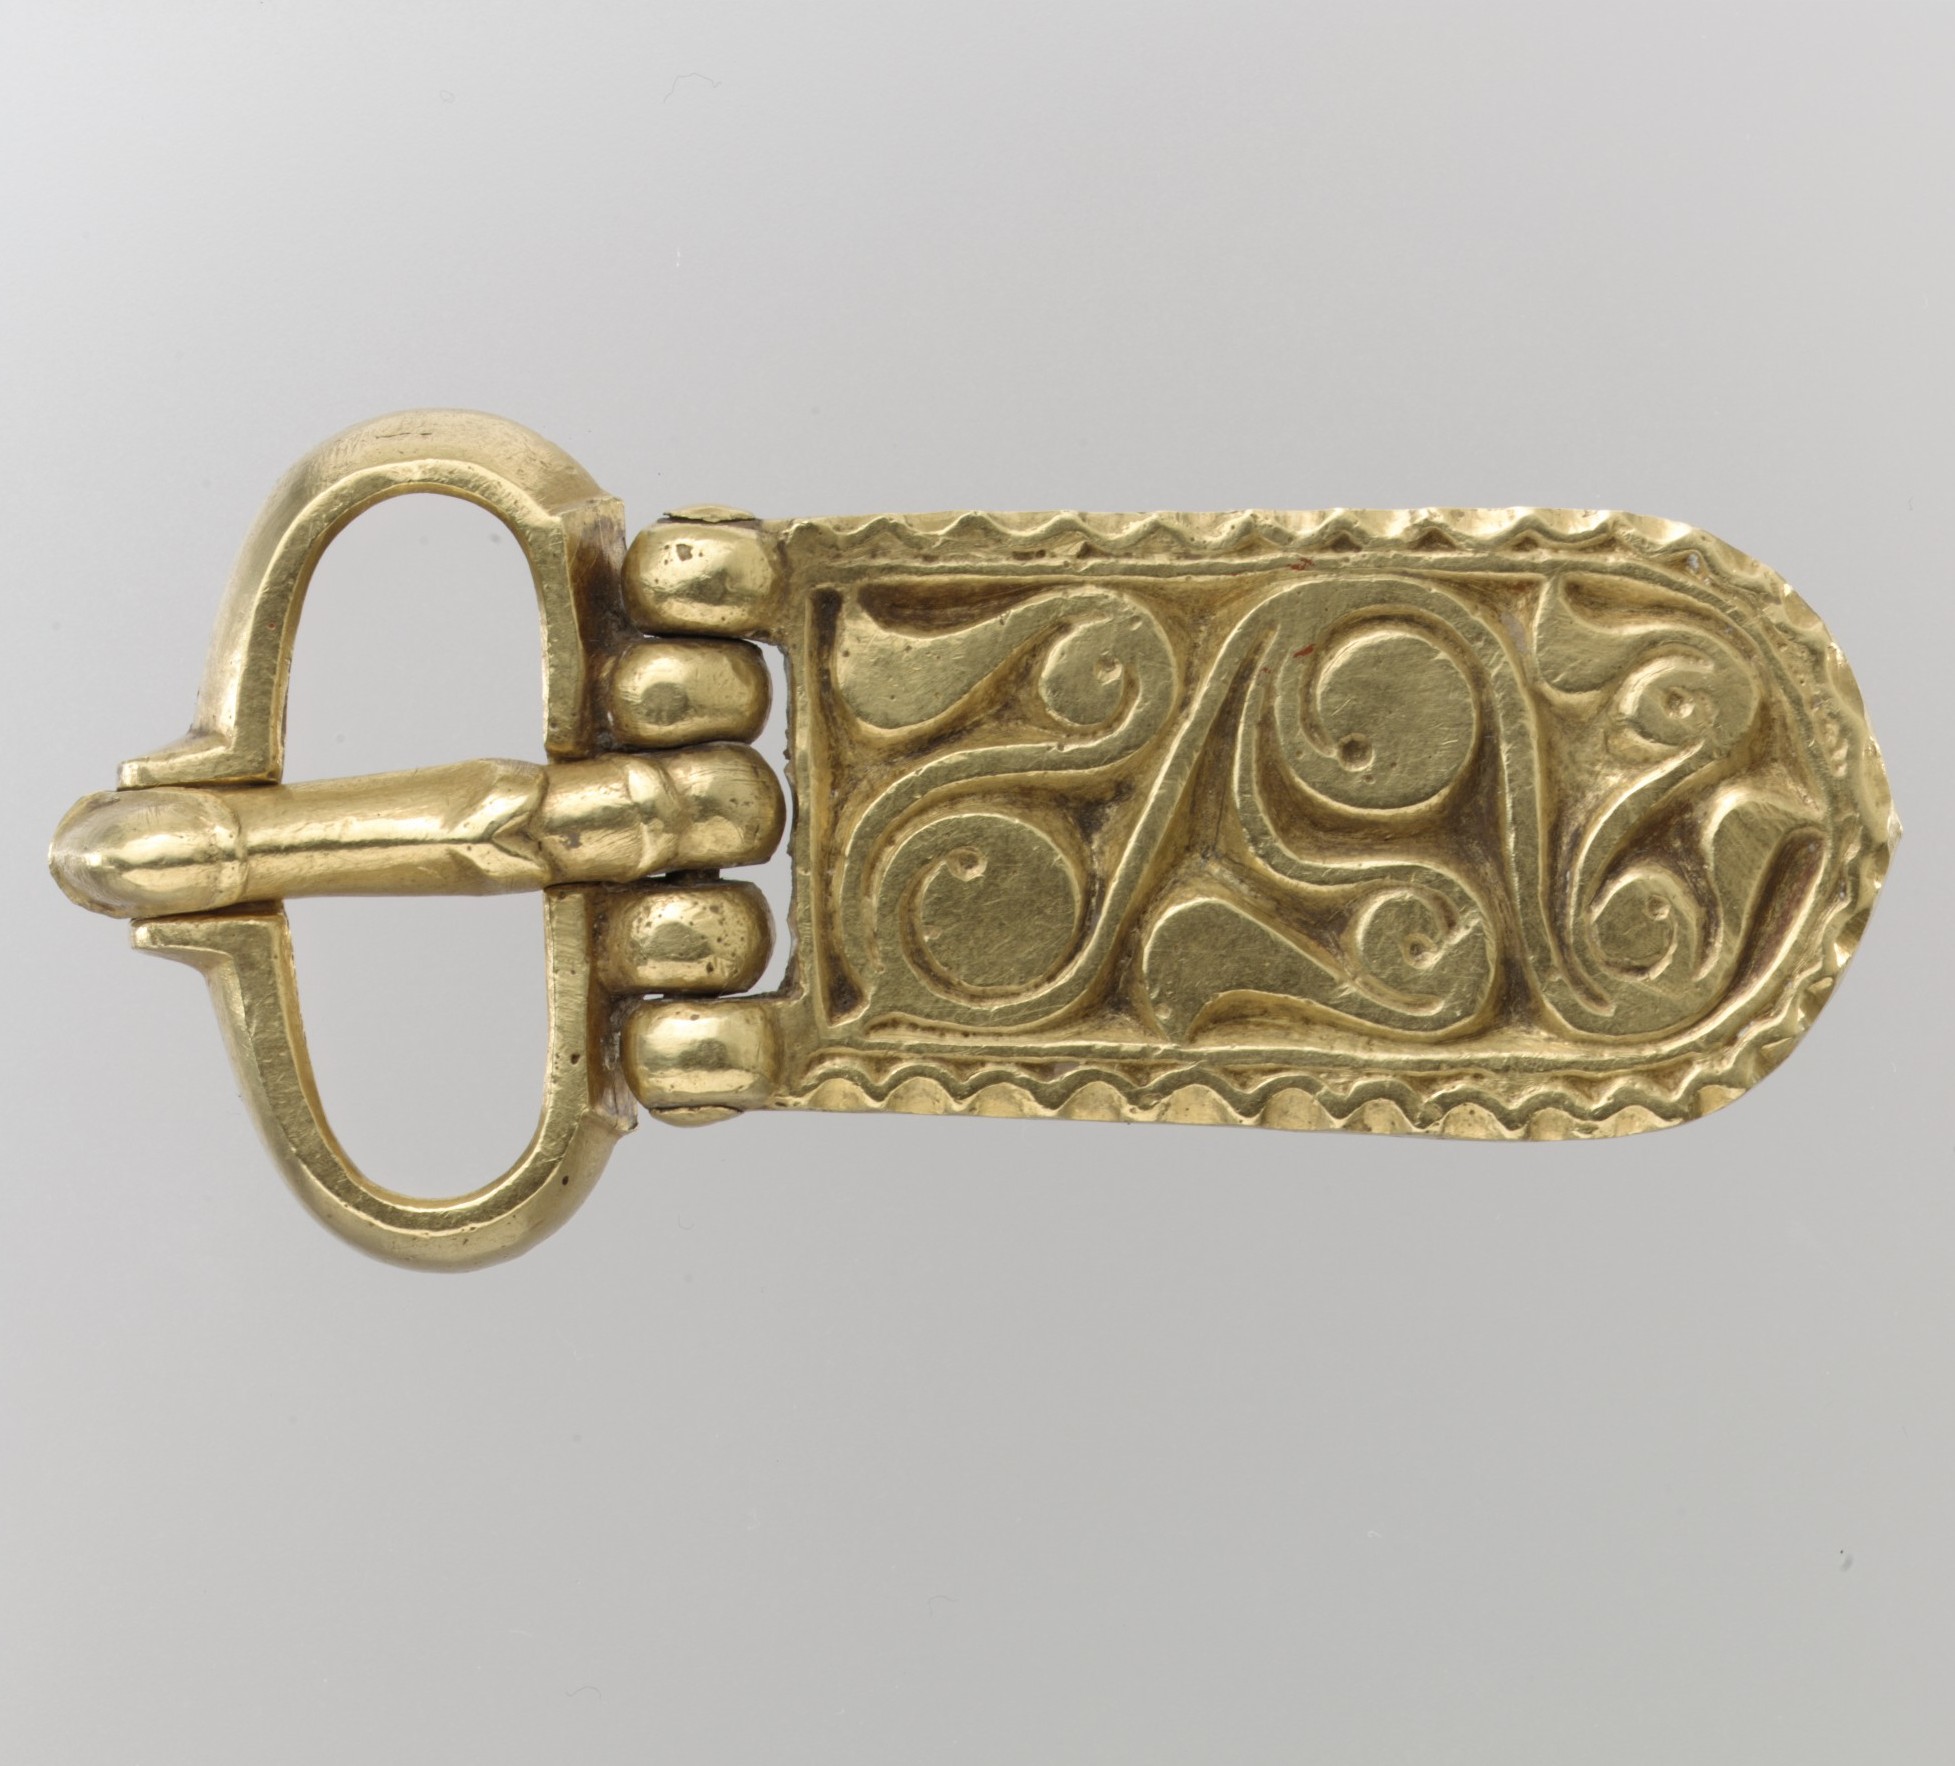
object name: buckle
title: Gold Buckle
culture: avar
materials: gold